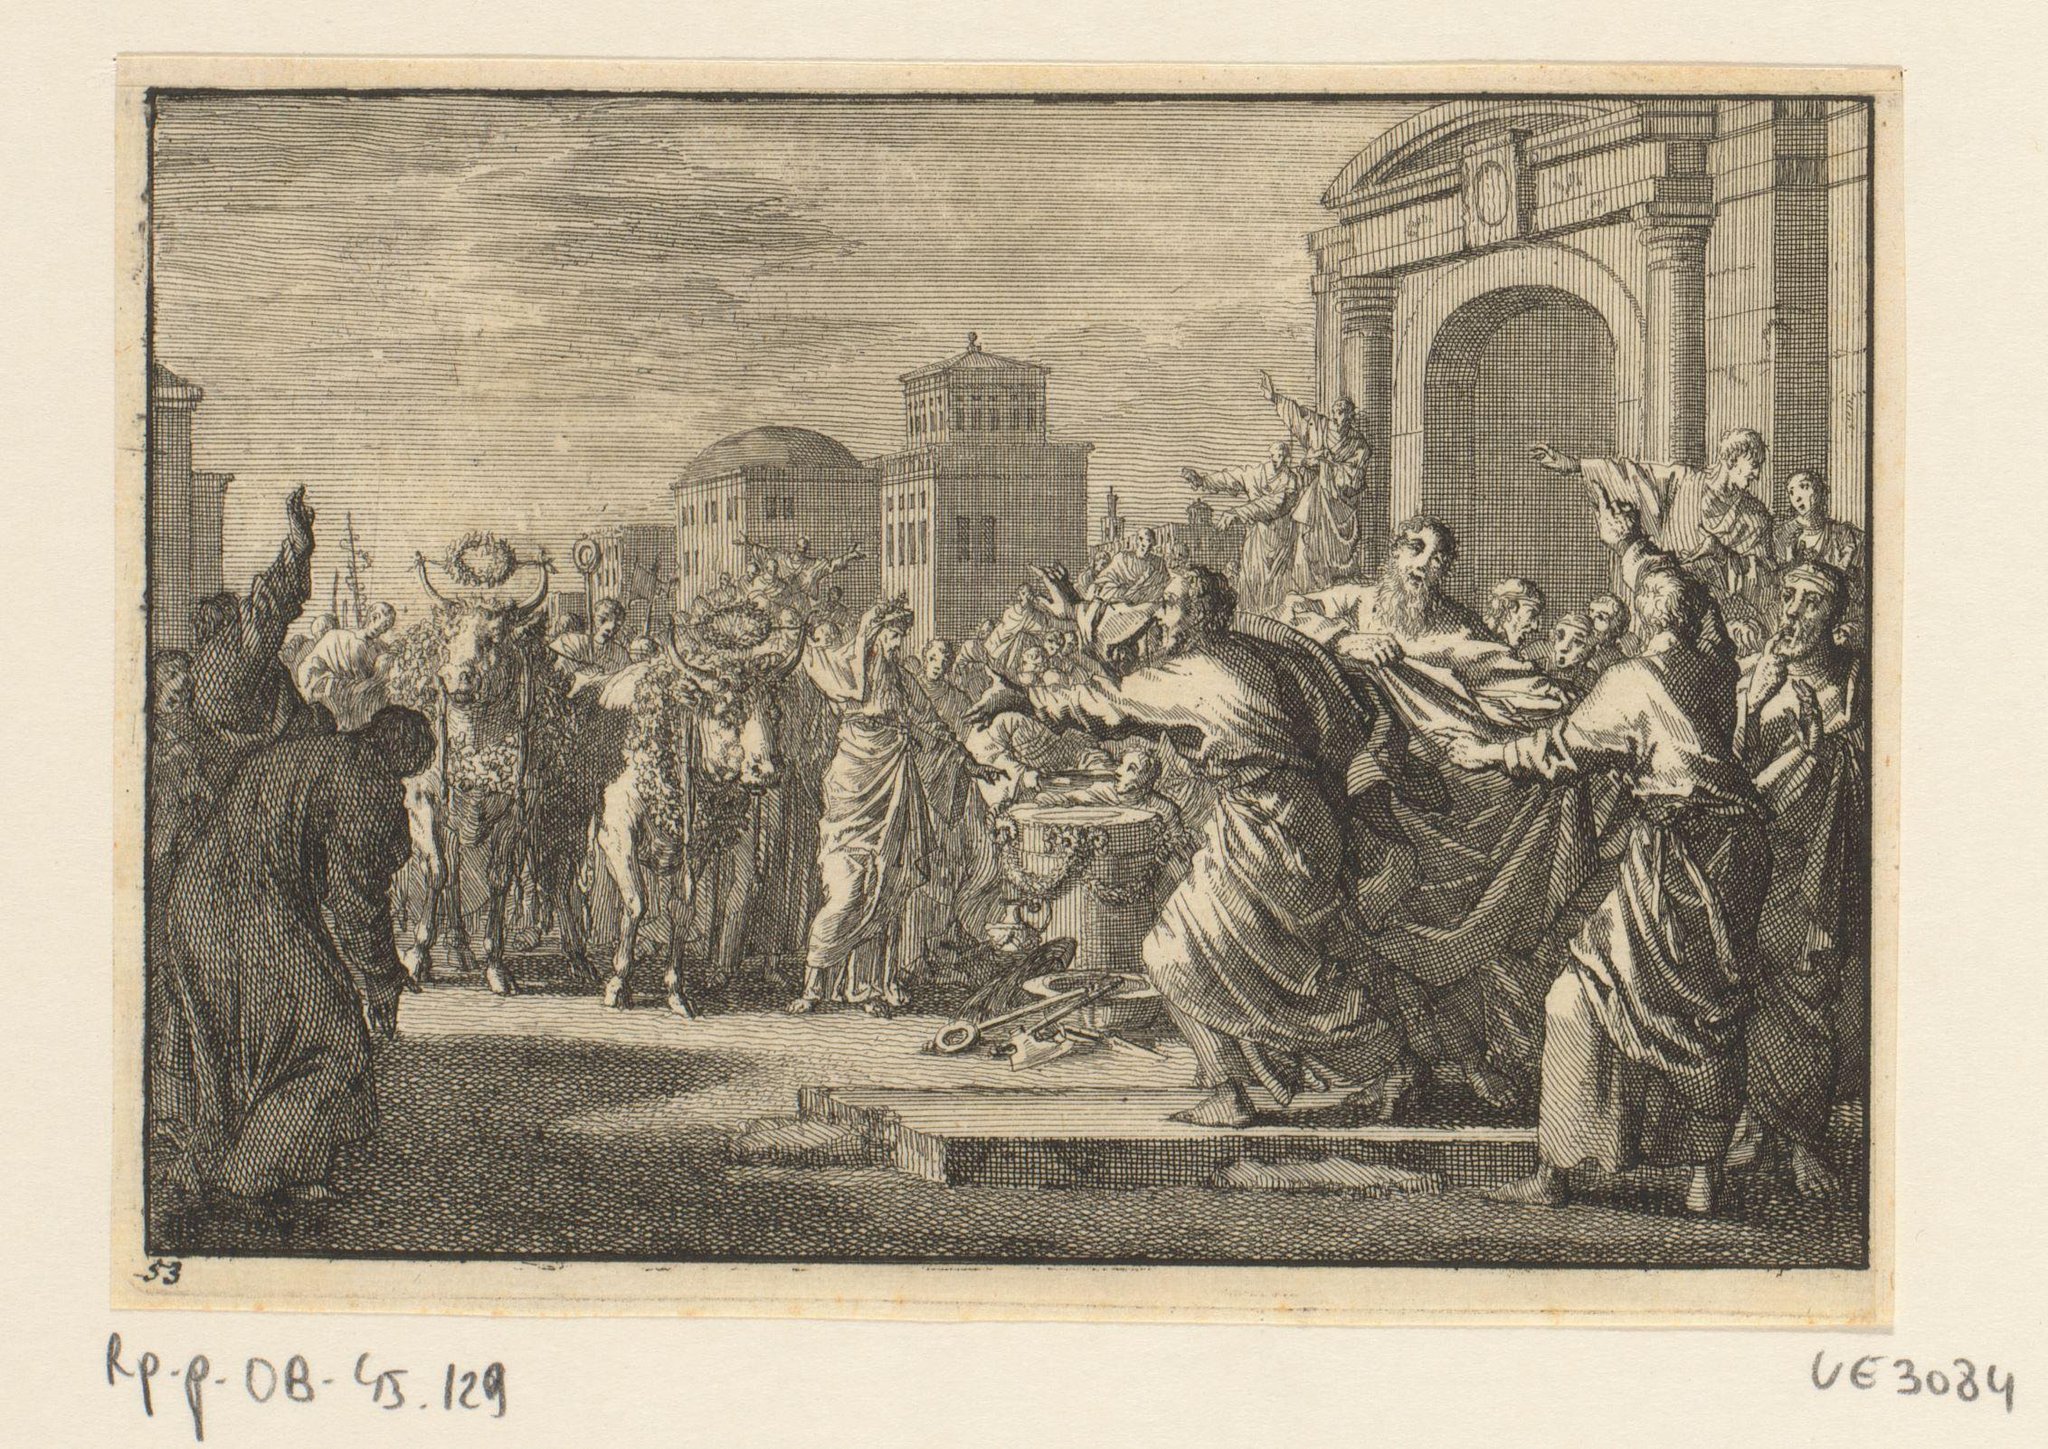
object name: print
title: Inwoners van Lystra willen runderen aan Paulus en Barnabas offeren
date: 1703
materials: paper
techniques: etching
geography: haarlem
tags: paul and barnabas tear their clothes, and try to prevent the sacrifice, preparation of the sacrificial celebration with oxen and garlands in front of the temple of jupiter ~ paul and barnabas at lystra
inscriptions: collector's mark: Lugt 2228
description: Proefdruk van een boekillustratie voor David Martin. Historie des Ouden en Nieuwen Testaments. Amsterdam, Pieter Mortier, 1703. Deel II. De boekillustraties voor de Mortierbijbel hebben verschillende staten en kopieën, waarbij de chronologische volgorde moeilijk te achterhalen valt. Als boekillustraties werden ze bovendien herhaaldelijk opnieuw gebruikt voor andere boekwerken.